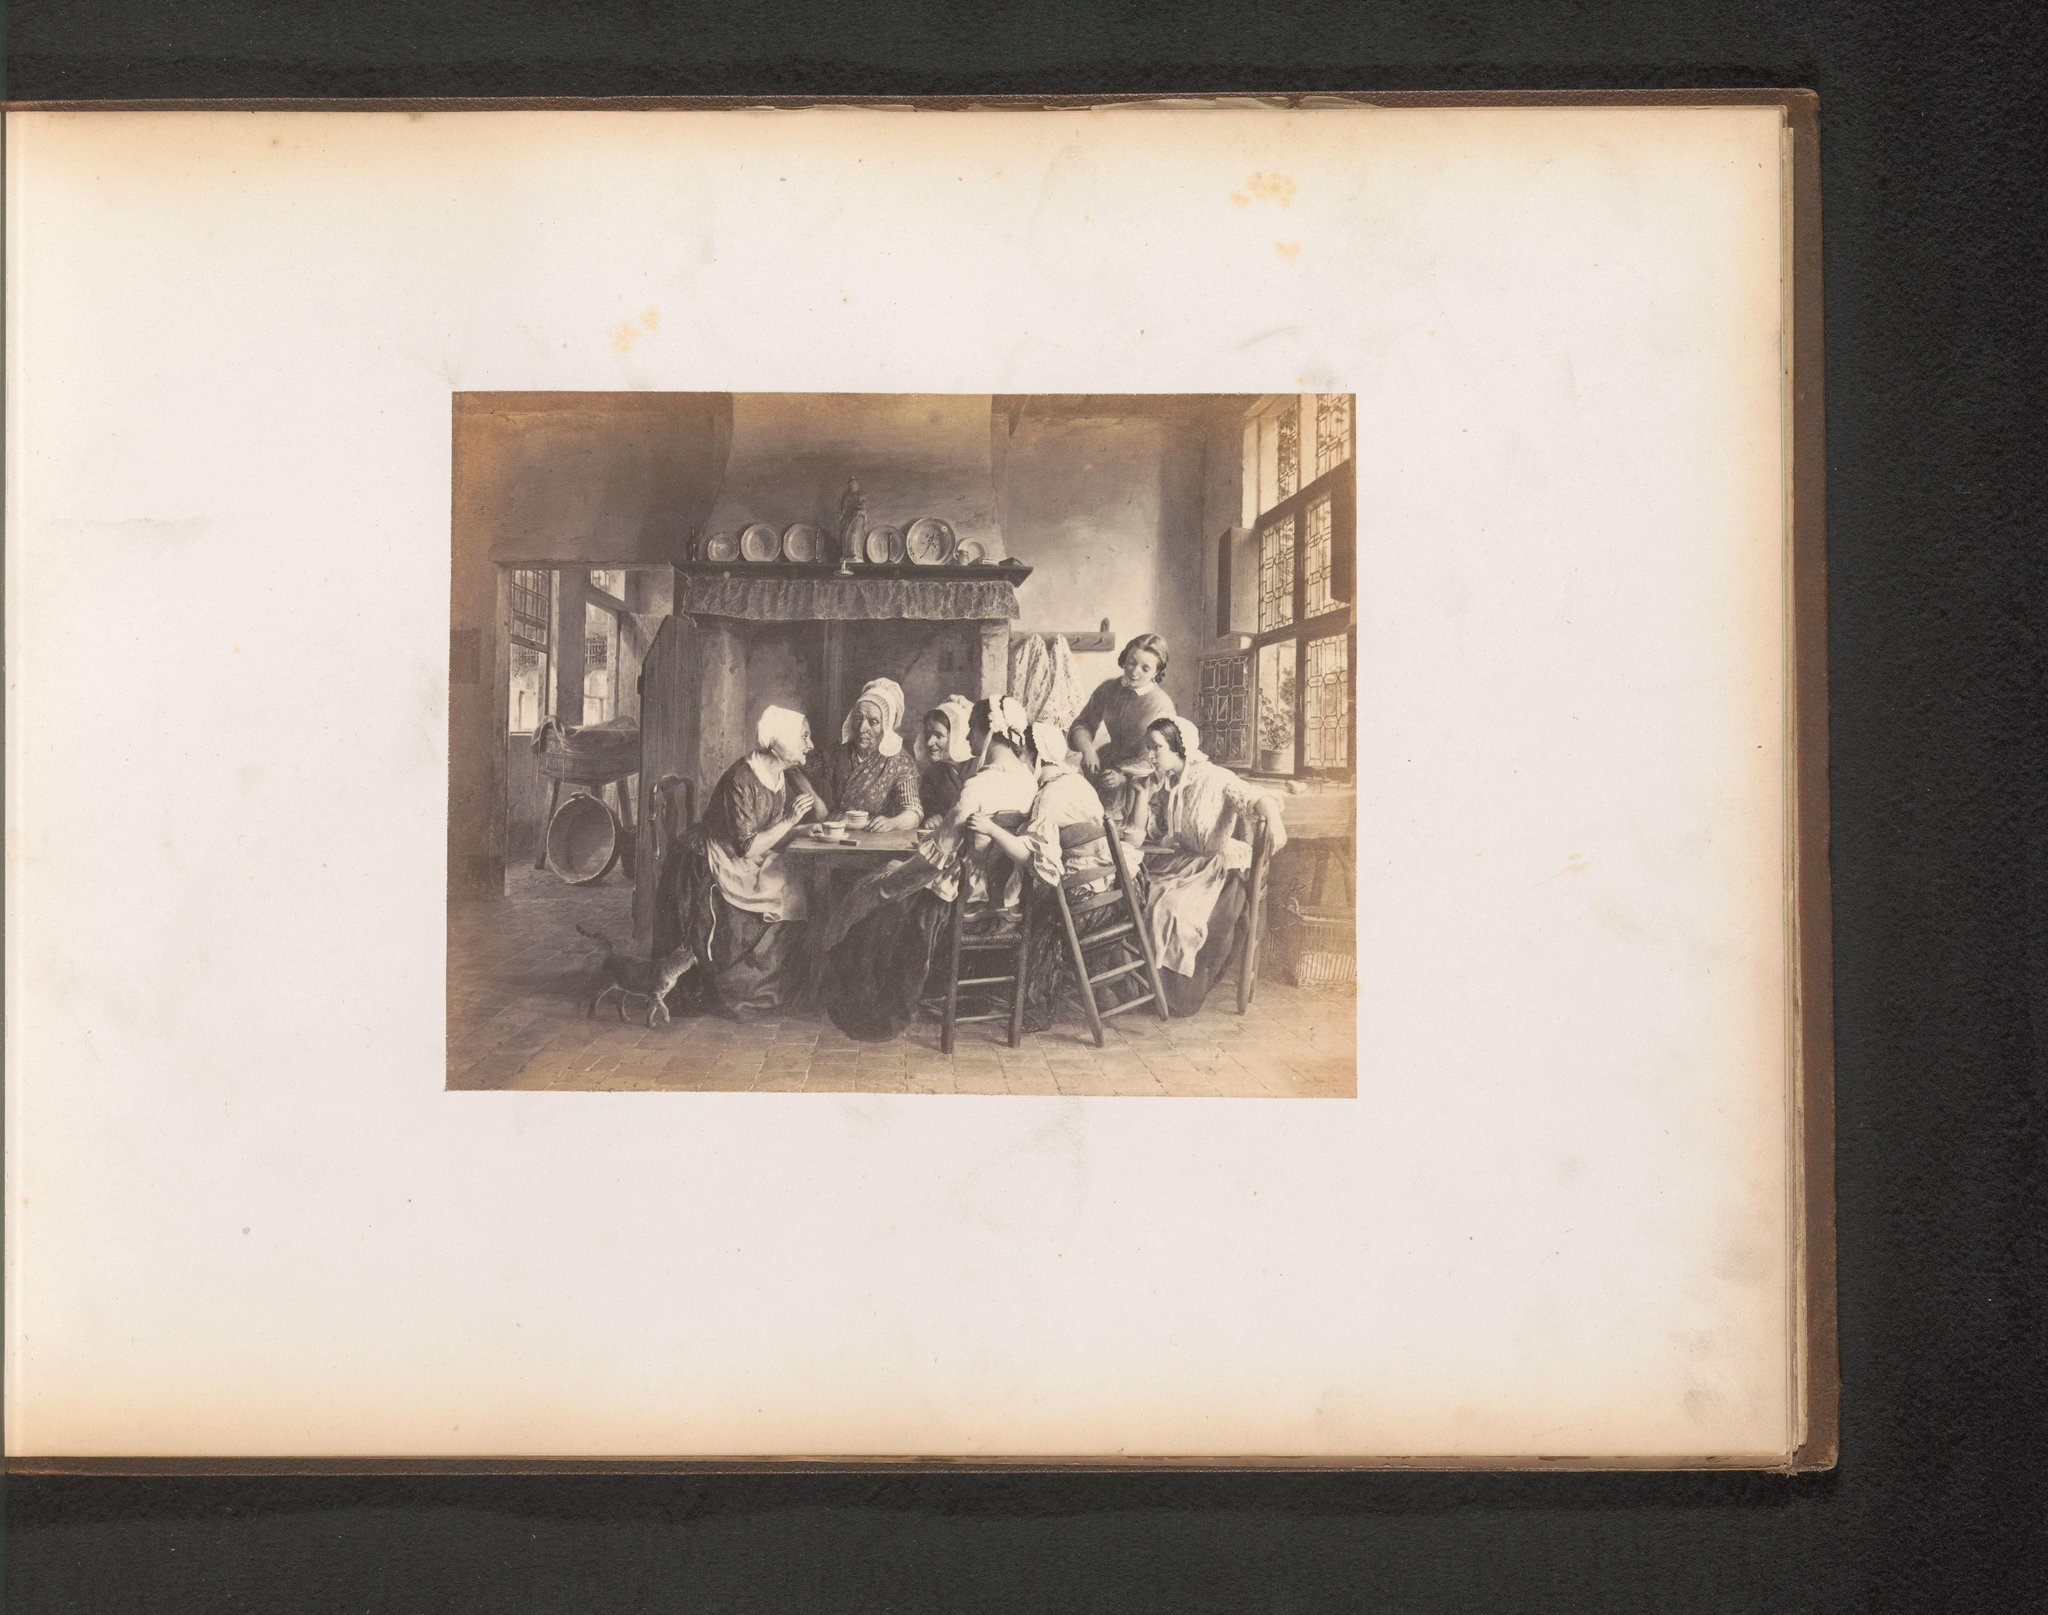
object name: photograph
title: Fotoreproductie van Je n'avais que 16 ans van François Antoine De Bruycker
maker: Anonymous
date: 1858-1863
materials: photographic support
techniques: albumen print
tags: adult woman, kitchen-interior, picture, painting